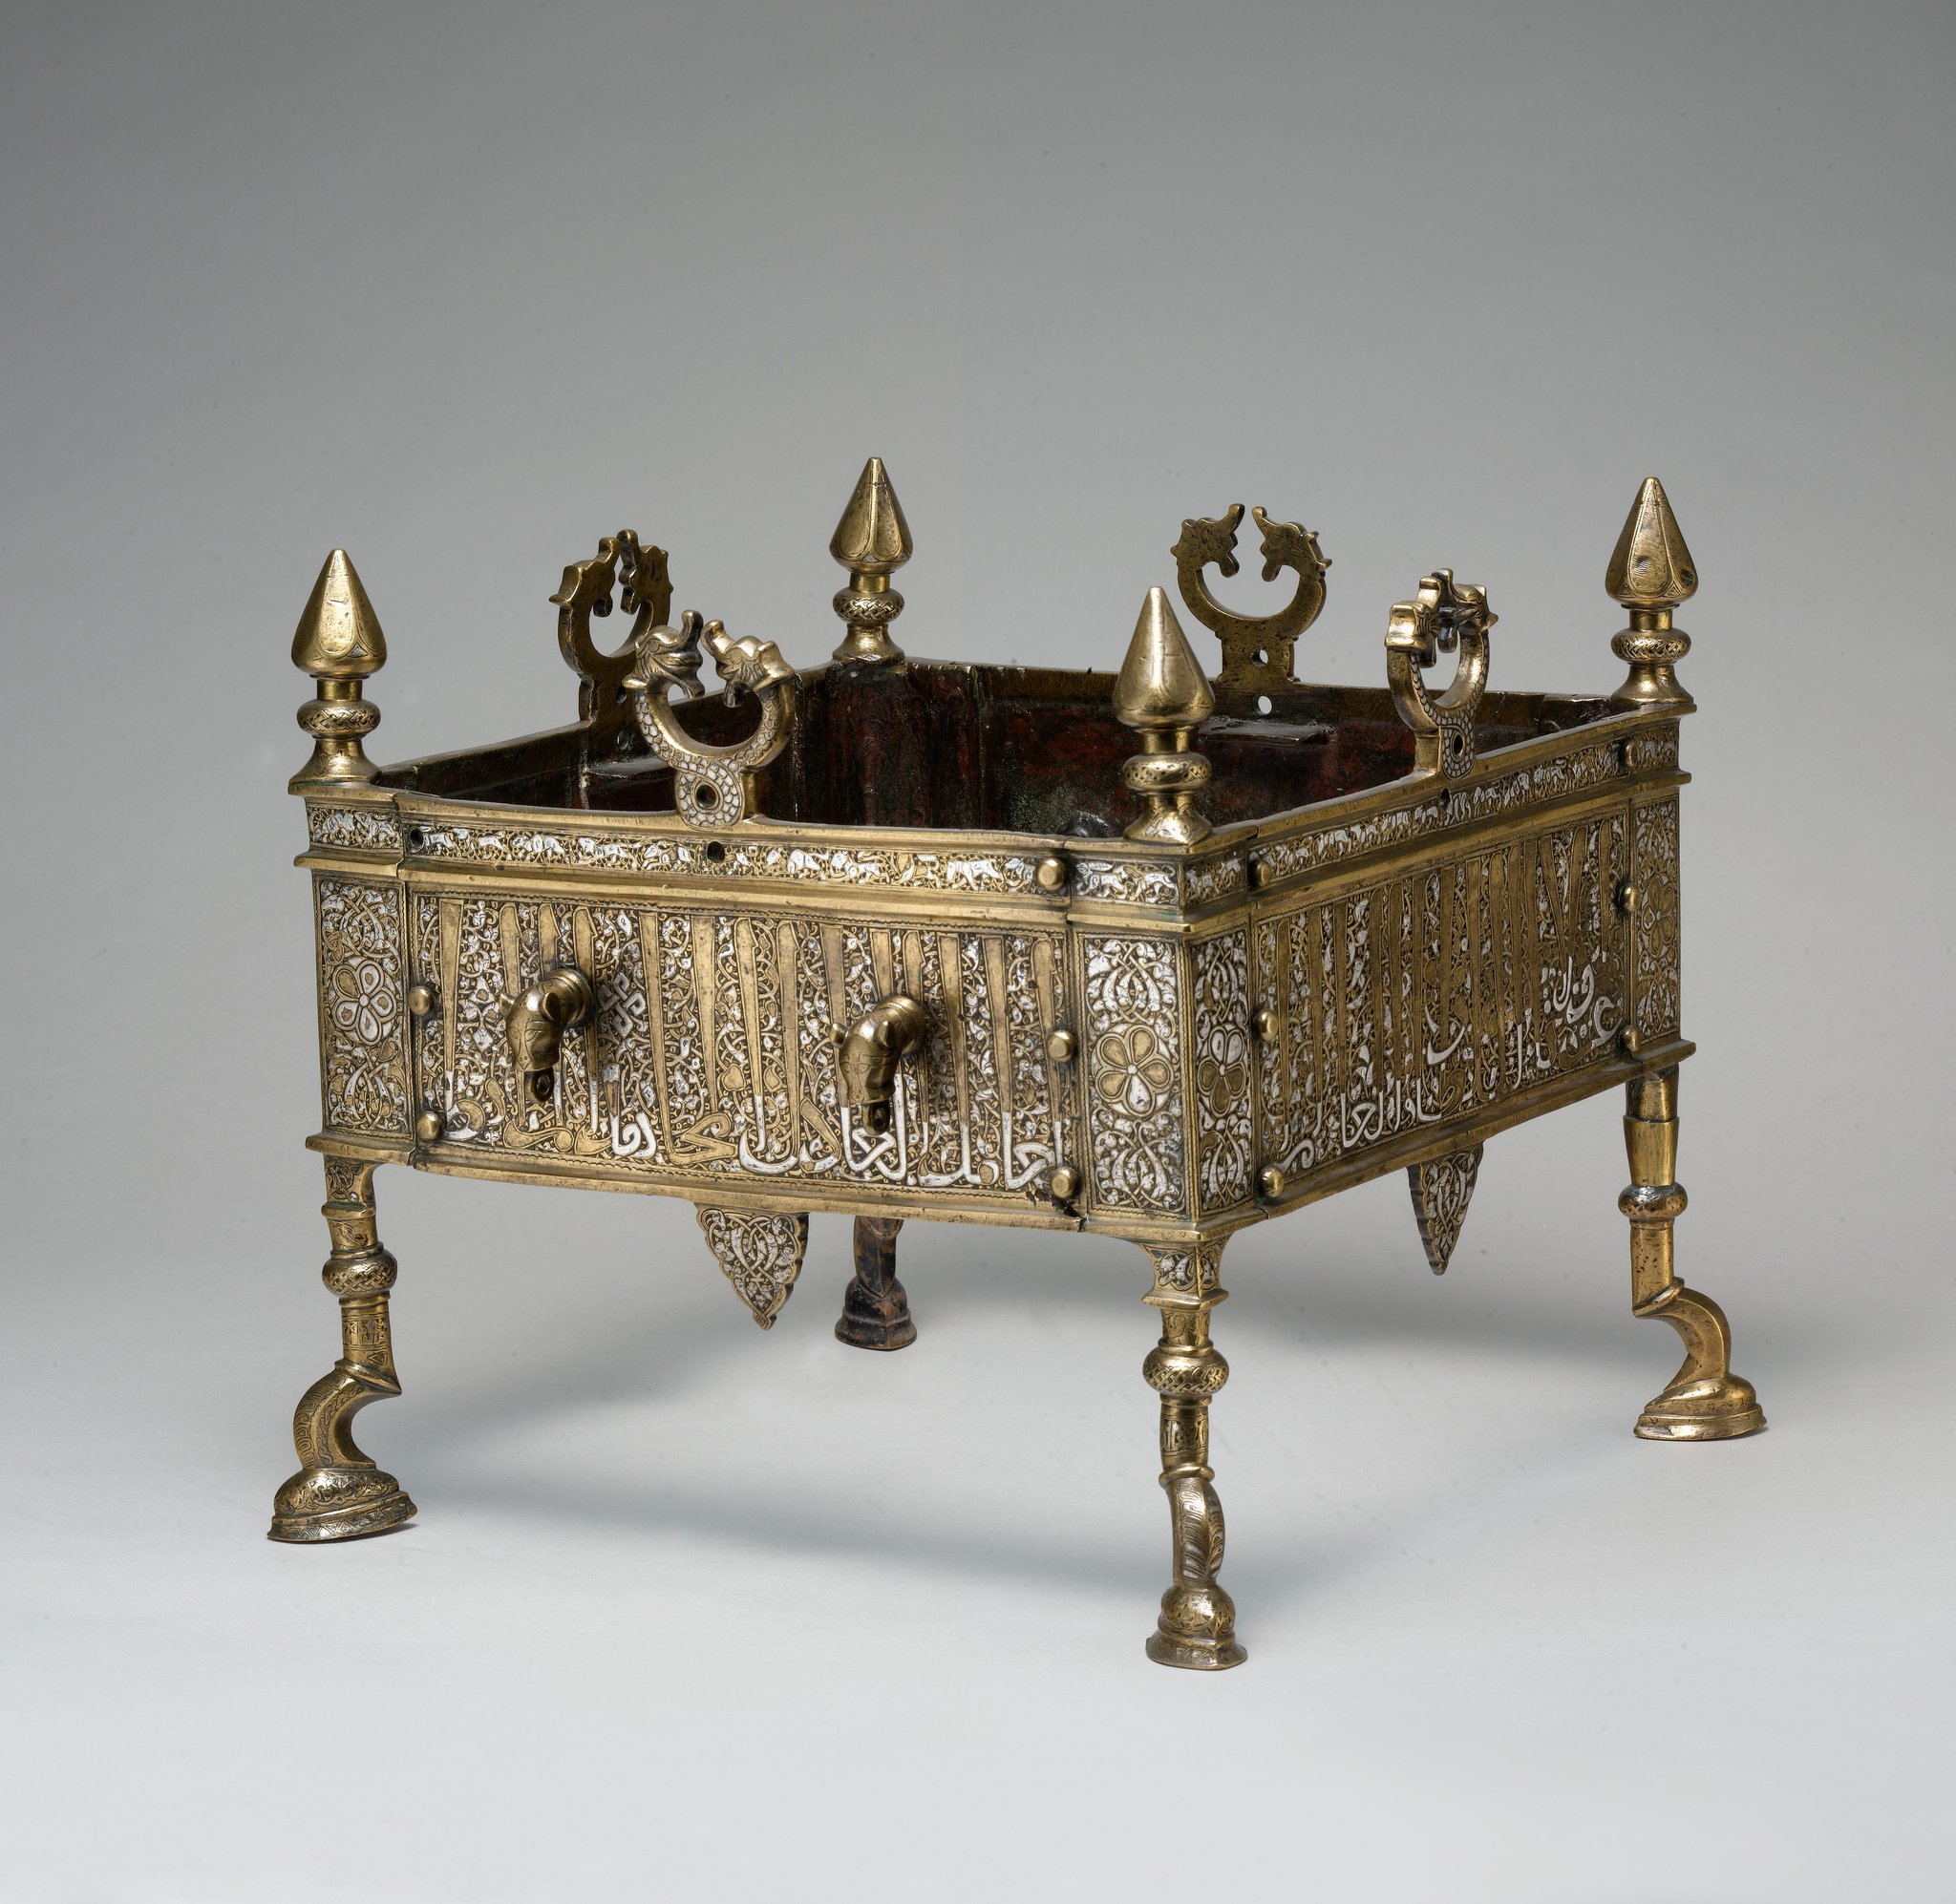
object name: brazier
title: Brazier of Rasulid Sultan al-Malik al-Muzaffar Shams al-Din Yusuf ibn 'Umar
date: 1251-1300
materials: brass, silver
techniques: casting, chasing, inlay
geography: egypt